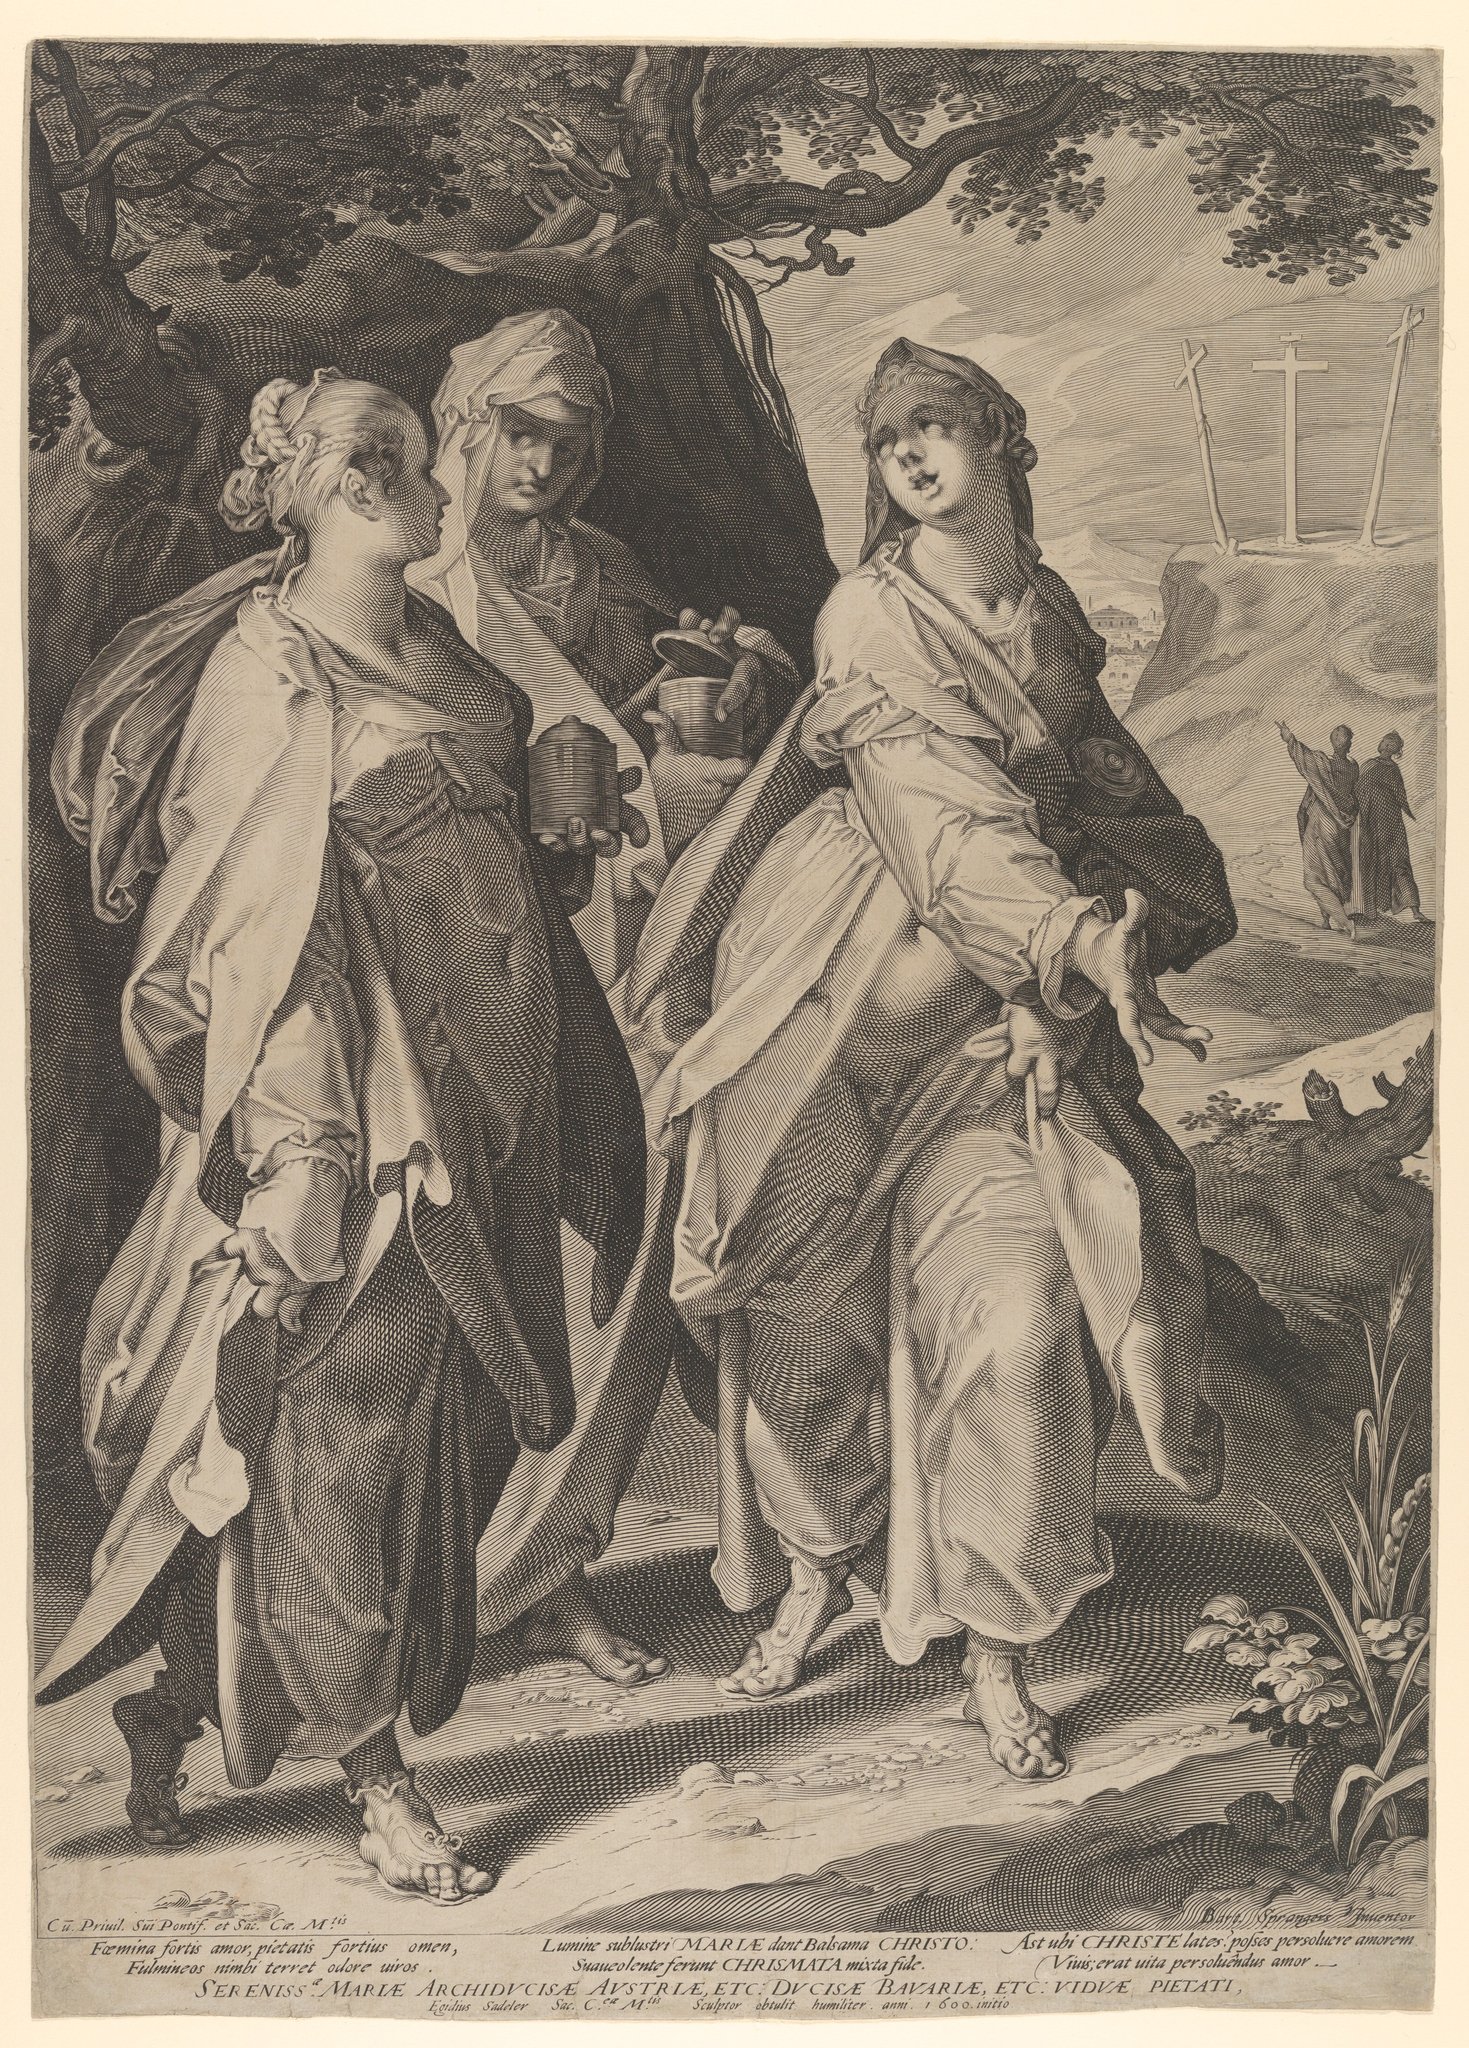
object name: print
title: The Three Women Returning from the Tomb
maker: aegidius sadeler (ii)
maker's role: artist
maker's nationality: flemish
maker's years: 1568-1629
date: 1585-1629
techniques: engraving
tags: women